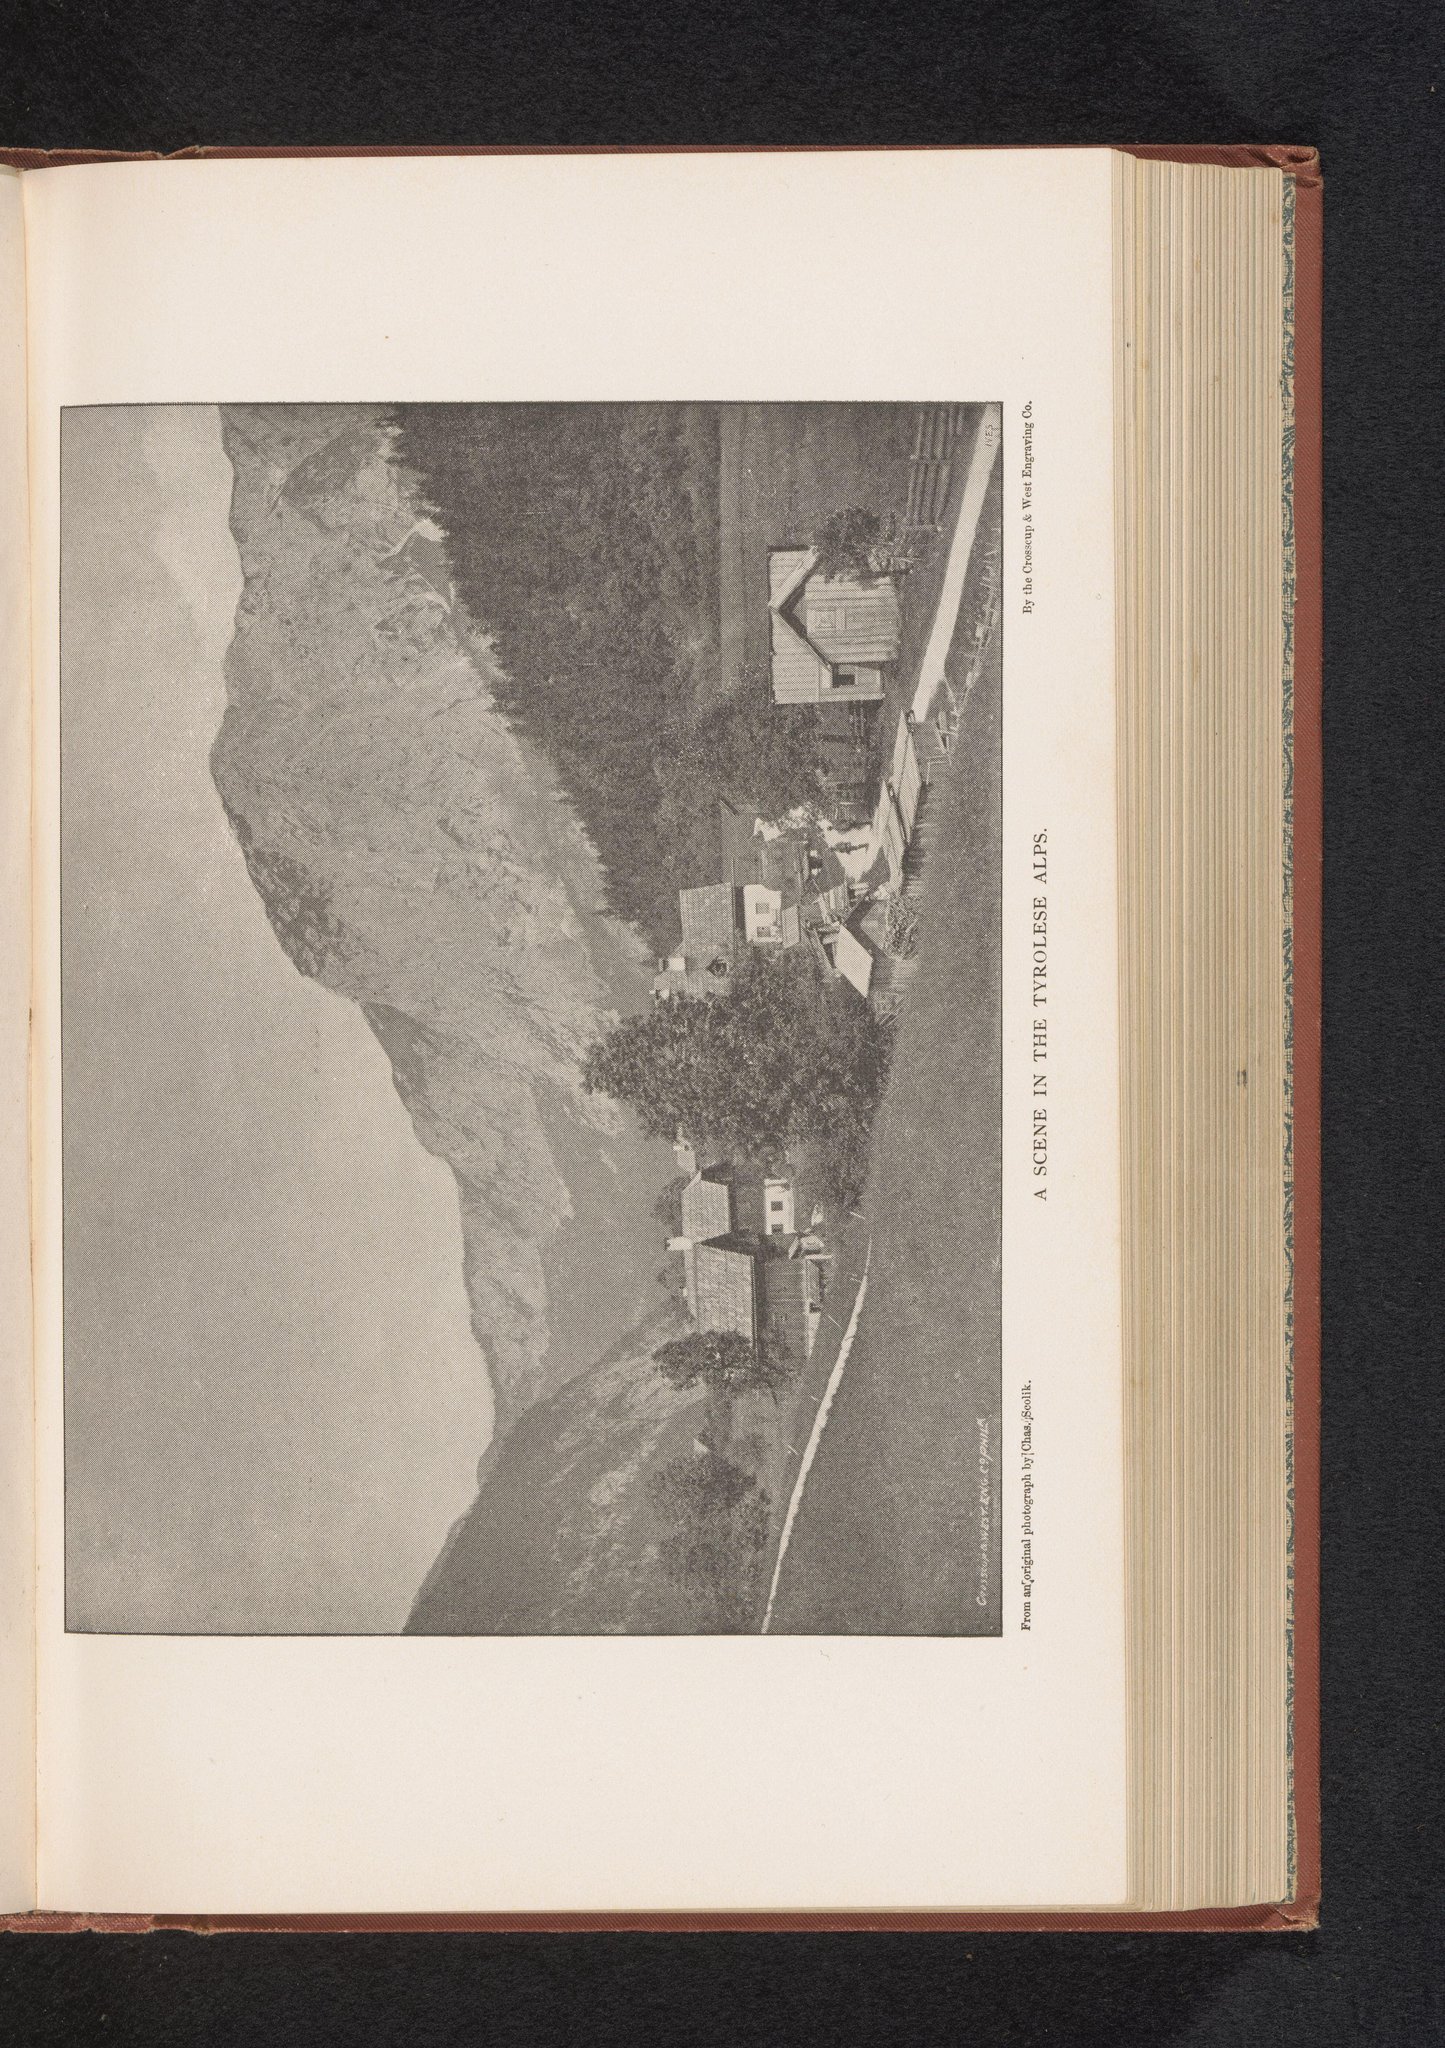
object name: page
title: Gezicht op een paar huizen in de Tiroolse Alpen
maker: charles scolik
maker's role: chemicus, fotograaf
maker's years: 1853-1928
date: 1884-1889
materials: paper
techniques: autotype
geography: philadelphia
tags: rural housing, e.g. country-house, villa, cottage, mountains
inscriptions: name: ‘IVES’